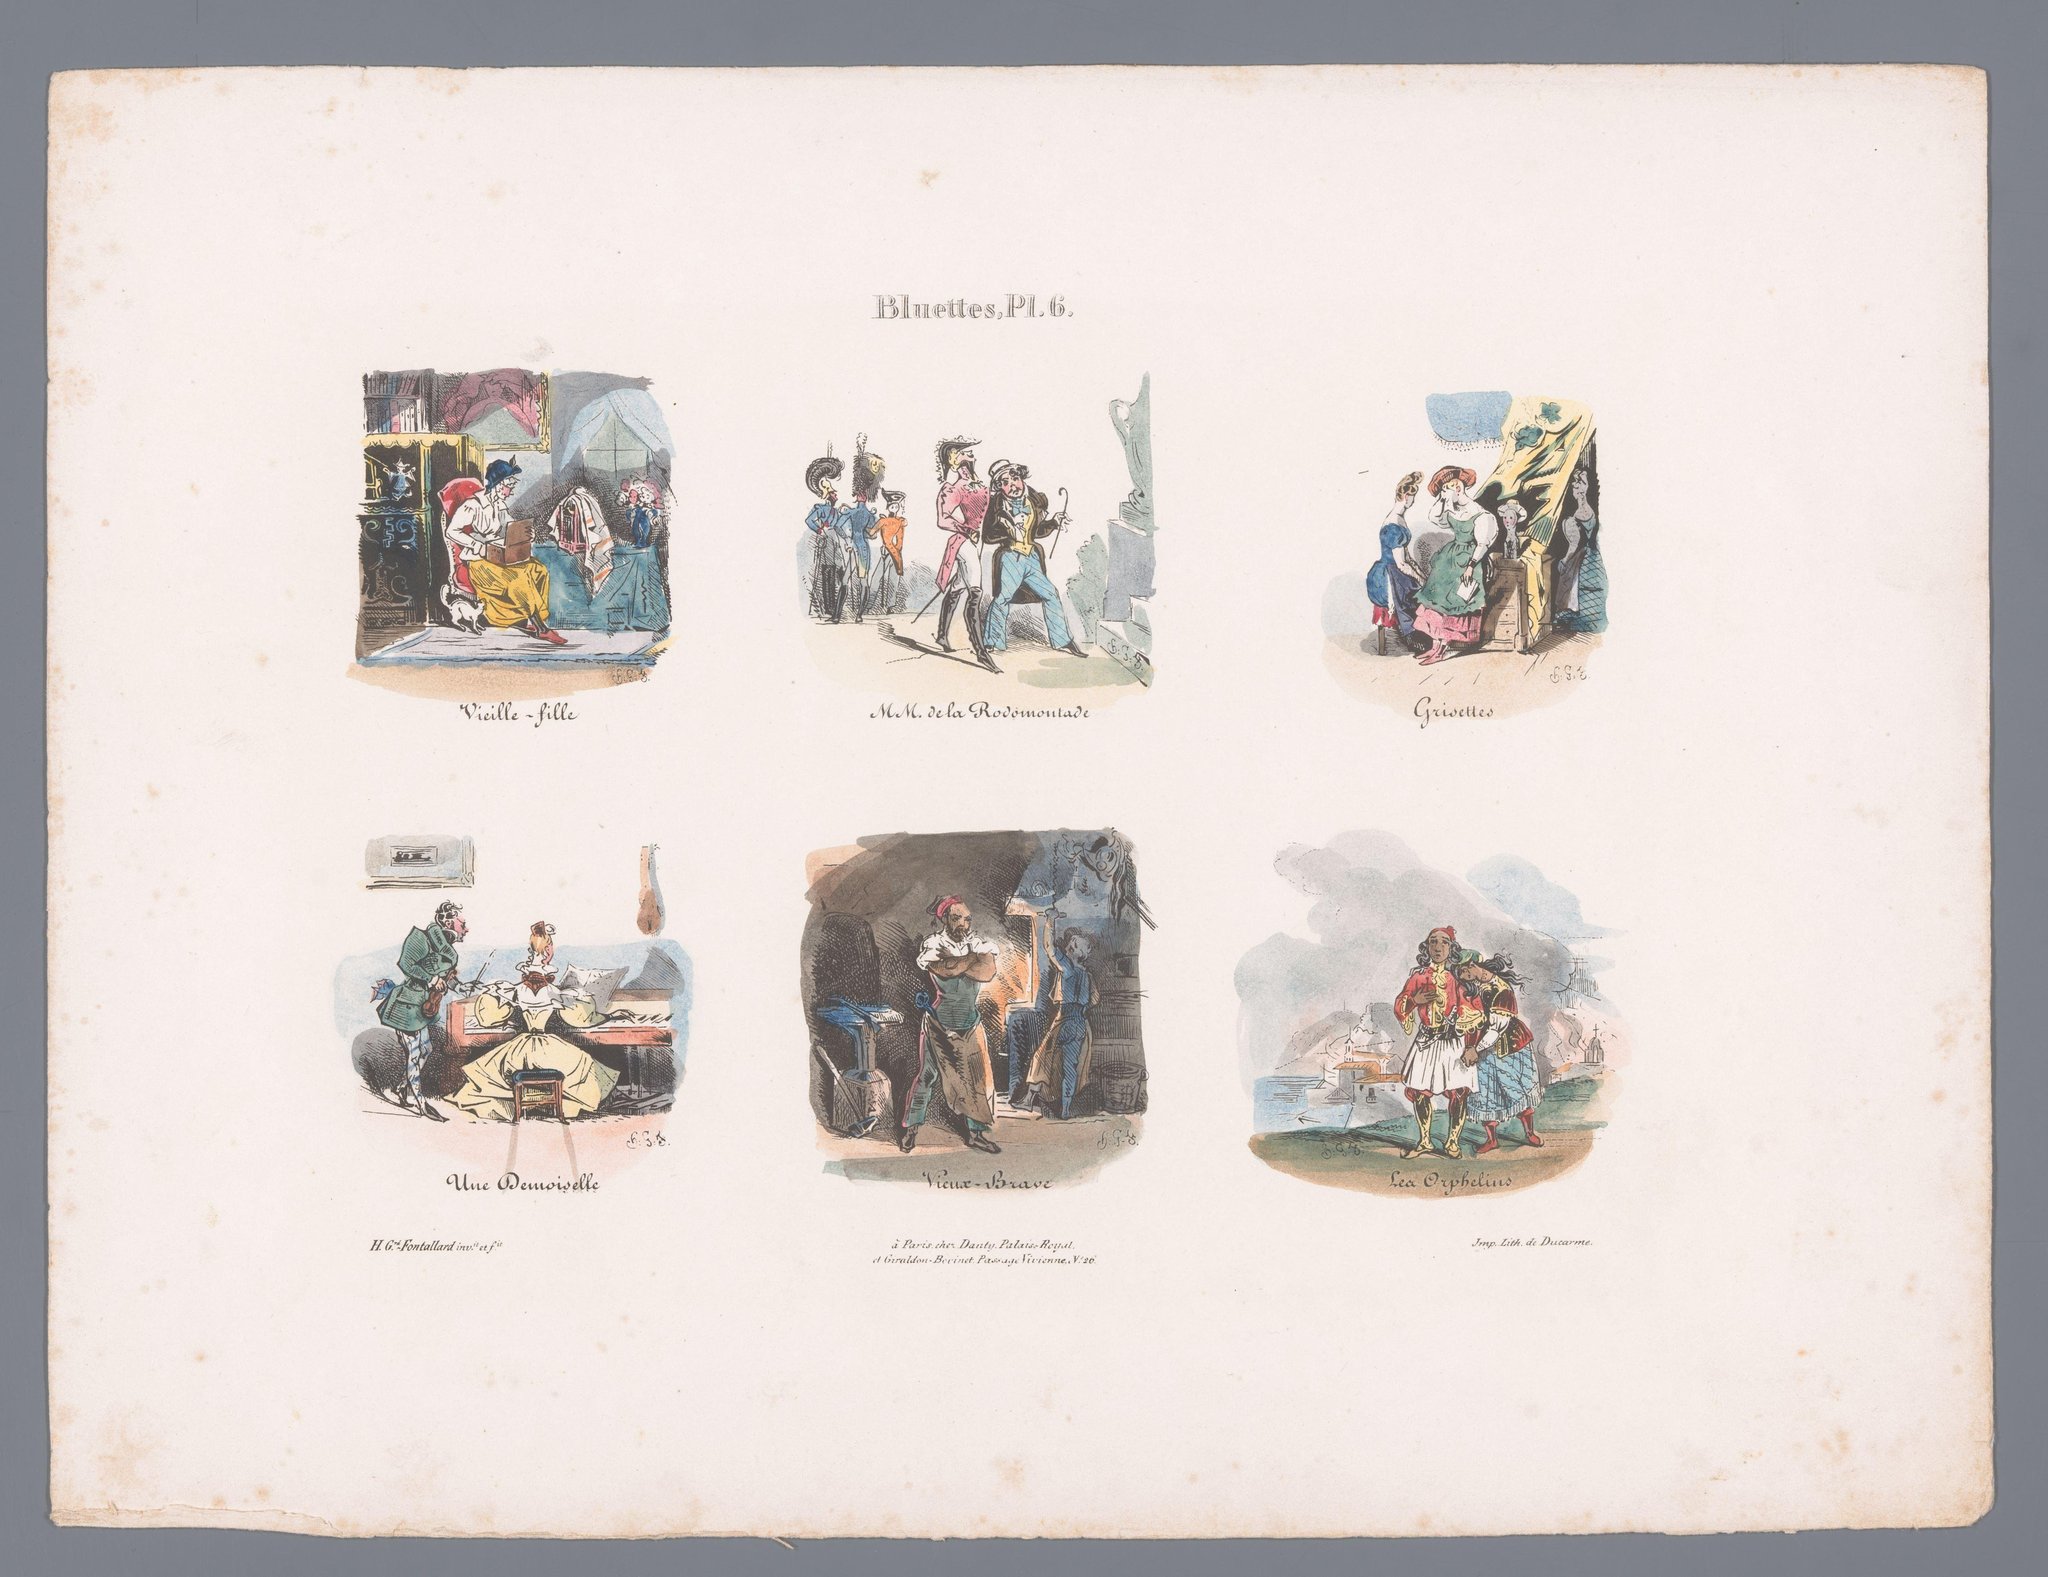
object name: print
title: Bluettes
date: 1828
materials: paper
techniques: hand coloring, lithograph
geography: paris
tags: various human types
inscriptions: collector's mark: Lugt 2228a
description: Prent maakt deel uit van een omslag met achttien prenten.